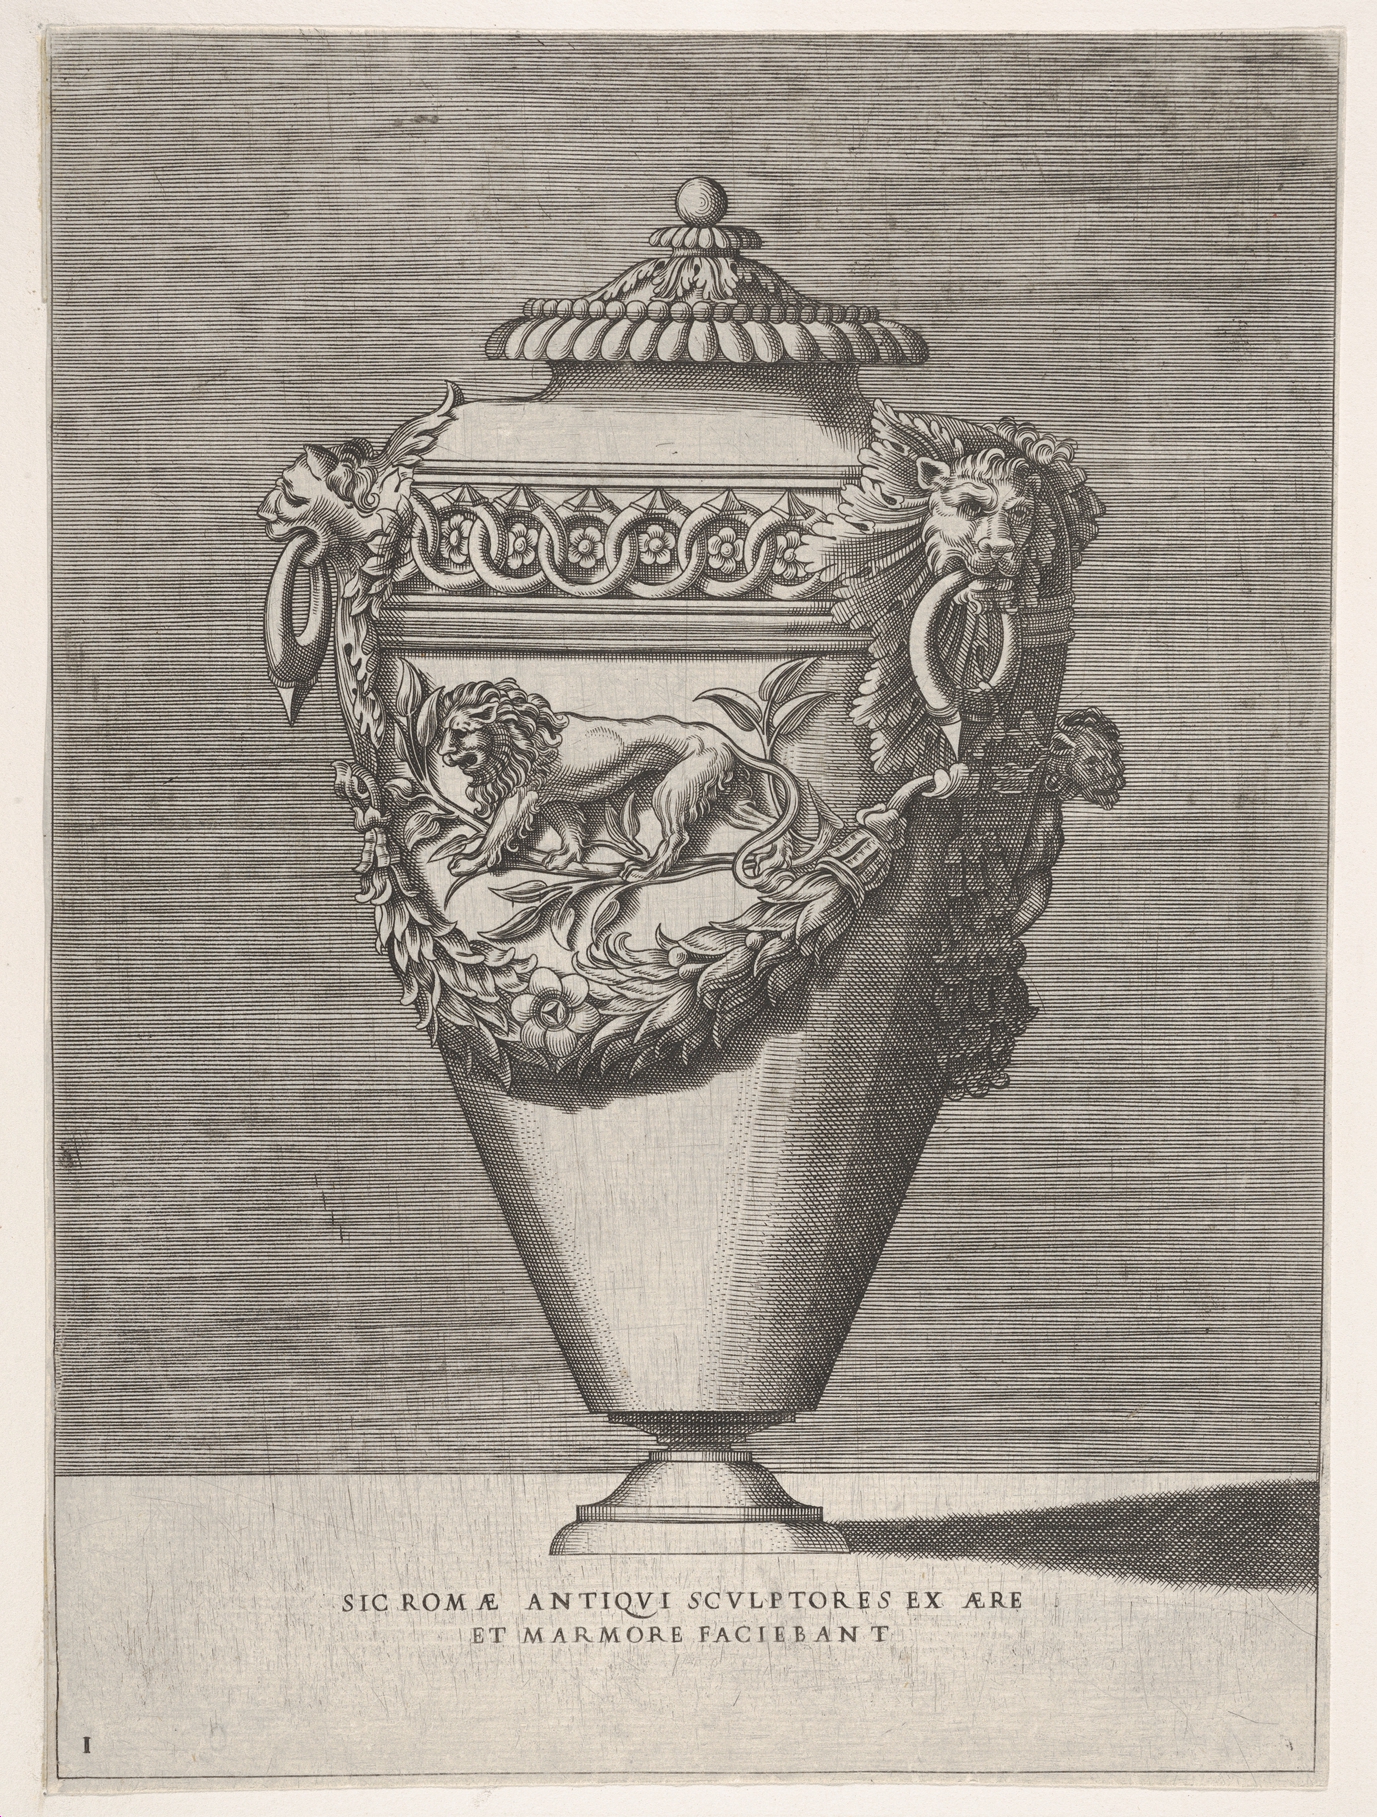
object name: print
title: Antique Lidded Urn Decorated with a Motif of Diamond Rings and Lions, from "Vases after the Antique"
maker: enea vico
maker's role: artist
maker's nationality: italian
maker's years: 1523-1567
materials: paper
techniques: engraving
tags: garlands,lions,urns